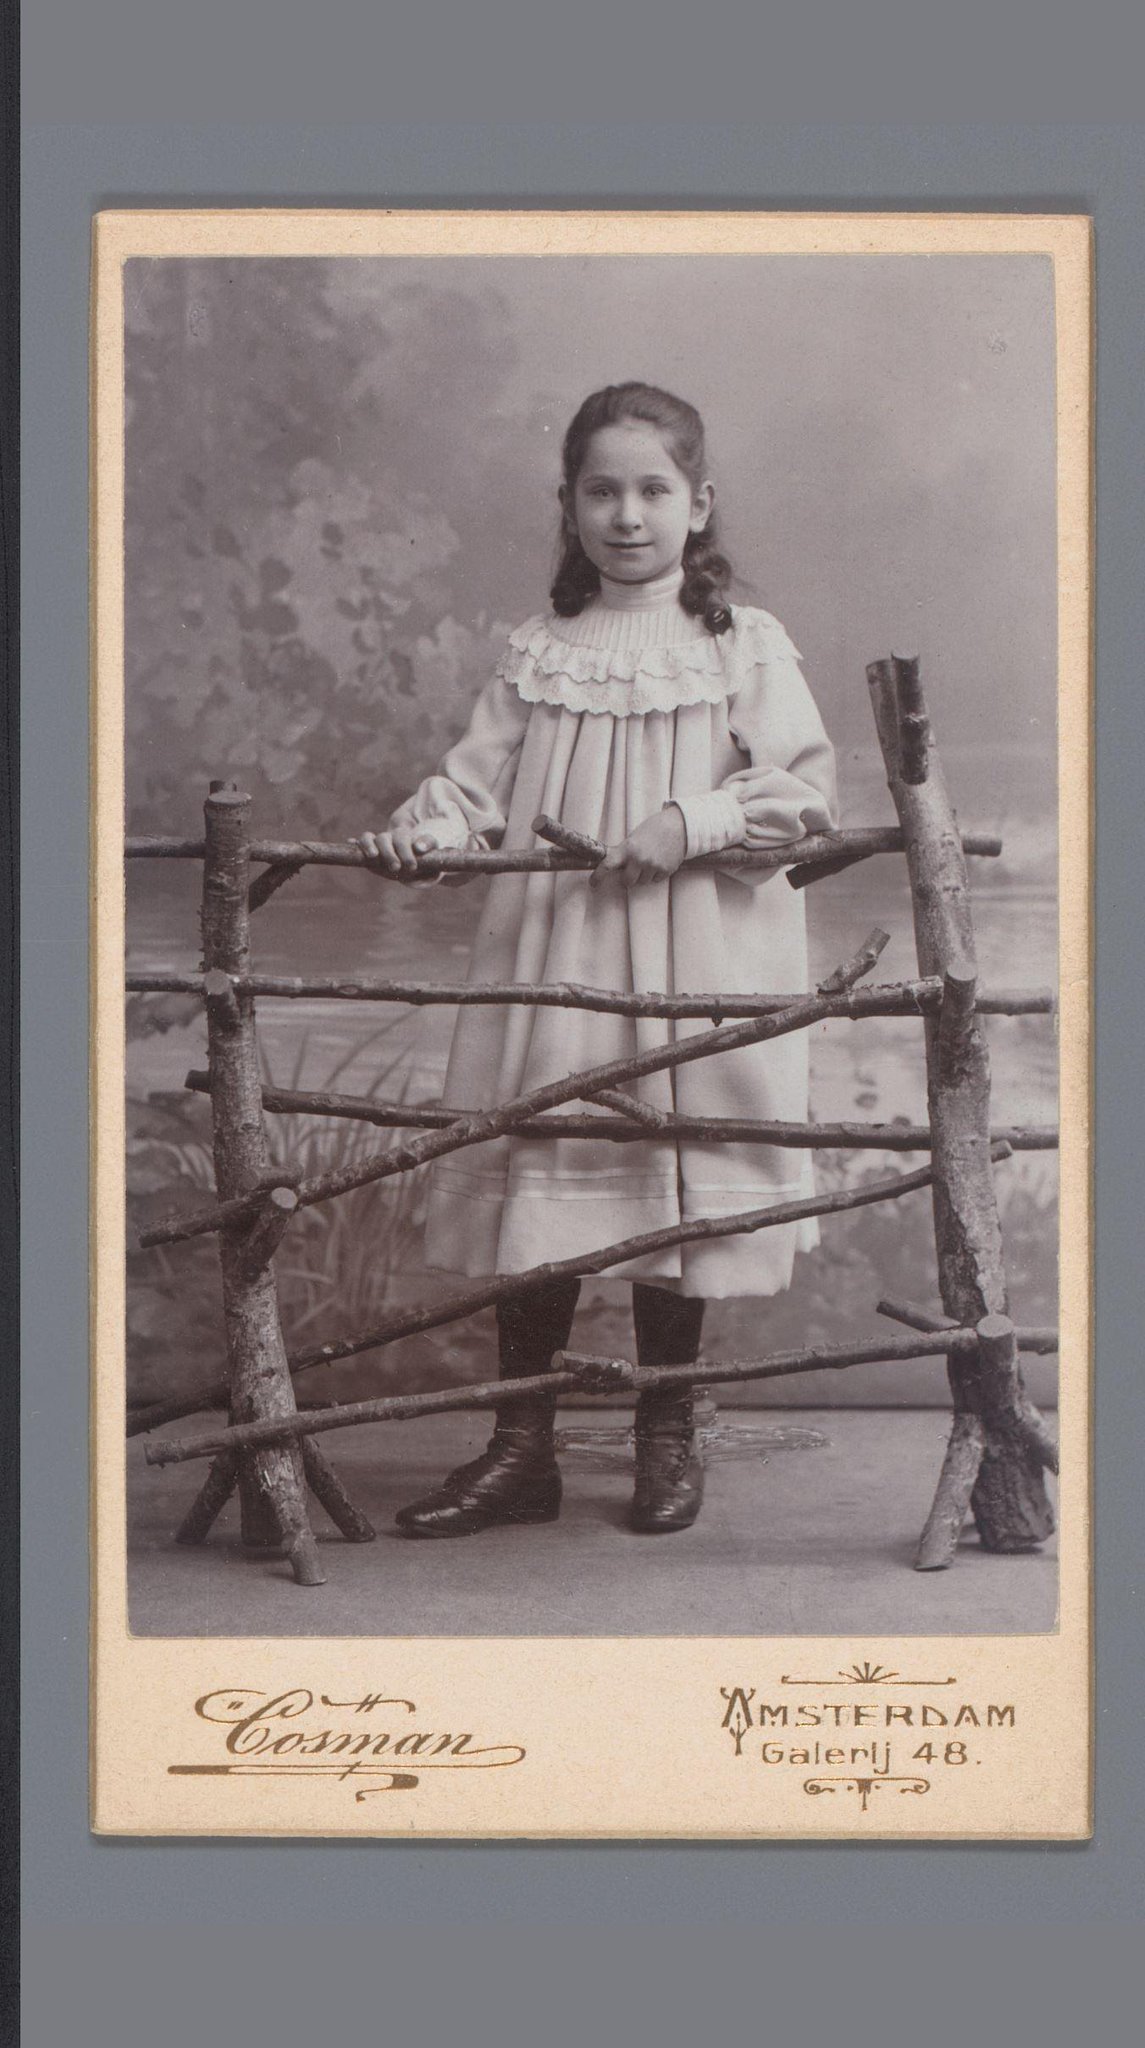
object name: carte de visite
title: Portret van Fietje Straub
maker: max cosman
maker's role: fotograaf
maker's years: 1852-1894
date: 1881-1903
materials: paper, cardboard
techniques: collodion silver print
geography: amsterdam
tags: historical persons, girl (child between toddler and youth)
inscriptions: address: ‘Amsterdam/ Galerij 48.’